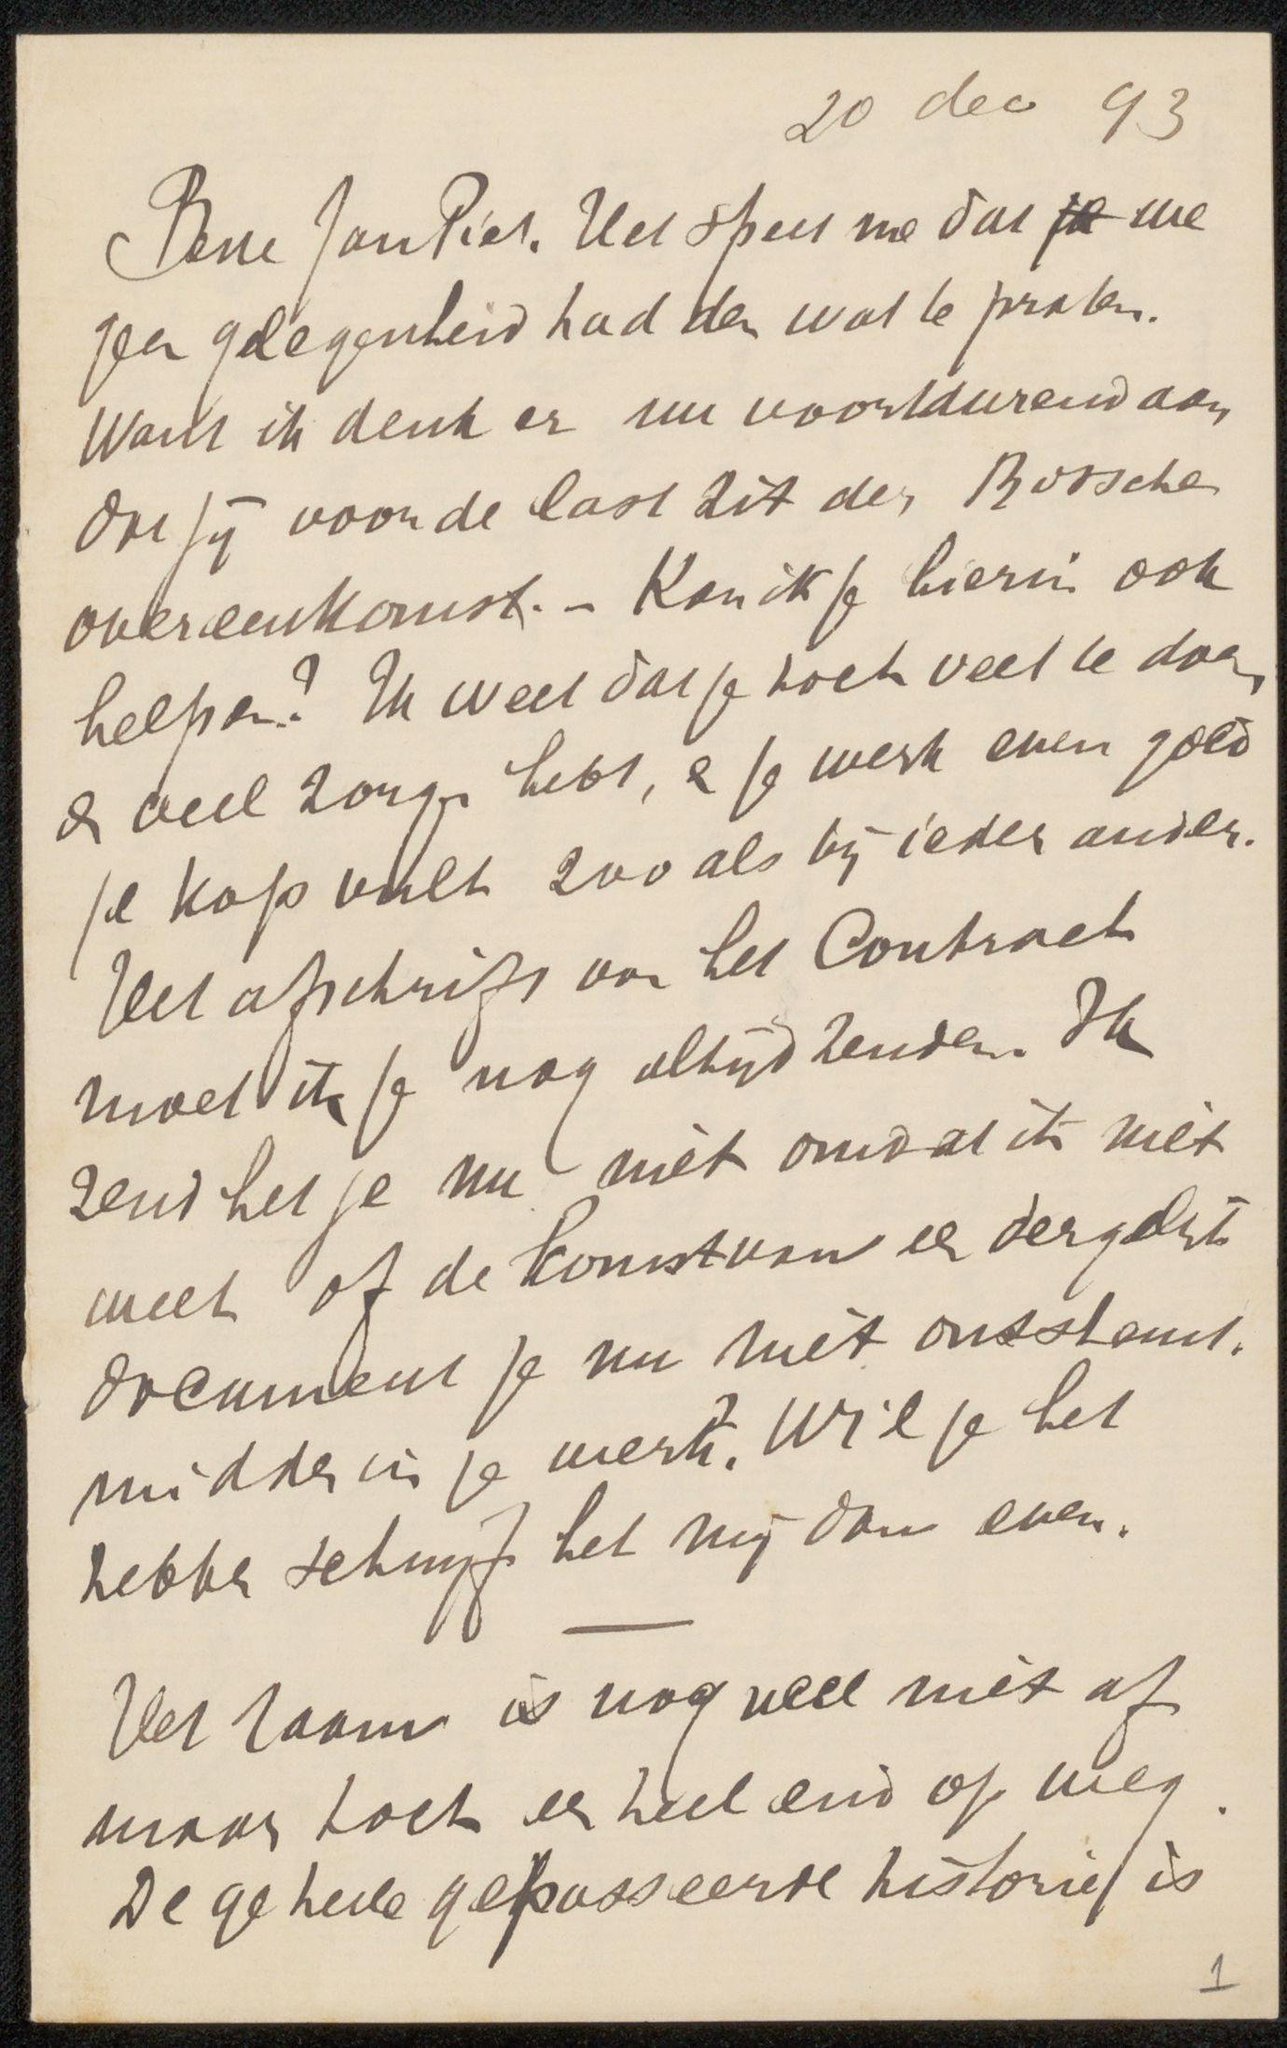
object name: letter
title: Brief aan Jan Veth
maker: antoon derkinderen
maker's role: draughtsman, painter, print maker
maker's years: 1859-1925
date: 1874-1925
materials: ink, paper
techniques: pen, writing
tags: dordrecht, designer, jan veth, jacob maris, applied arts, arts and crafts; industrial design, printed matter, den bosch, gouda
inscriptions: collector's mark: ‘RPK’, watermark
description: Brief gedateerd 20 dec 93 in latere hand.